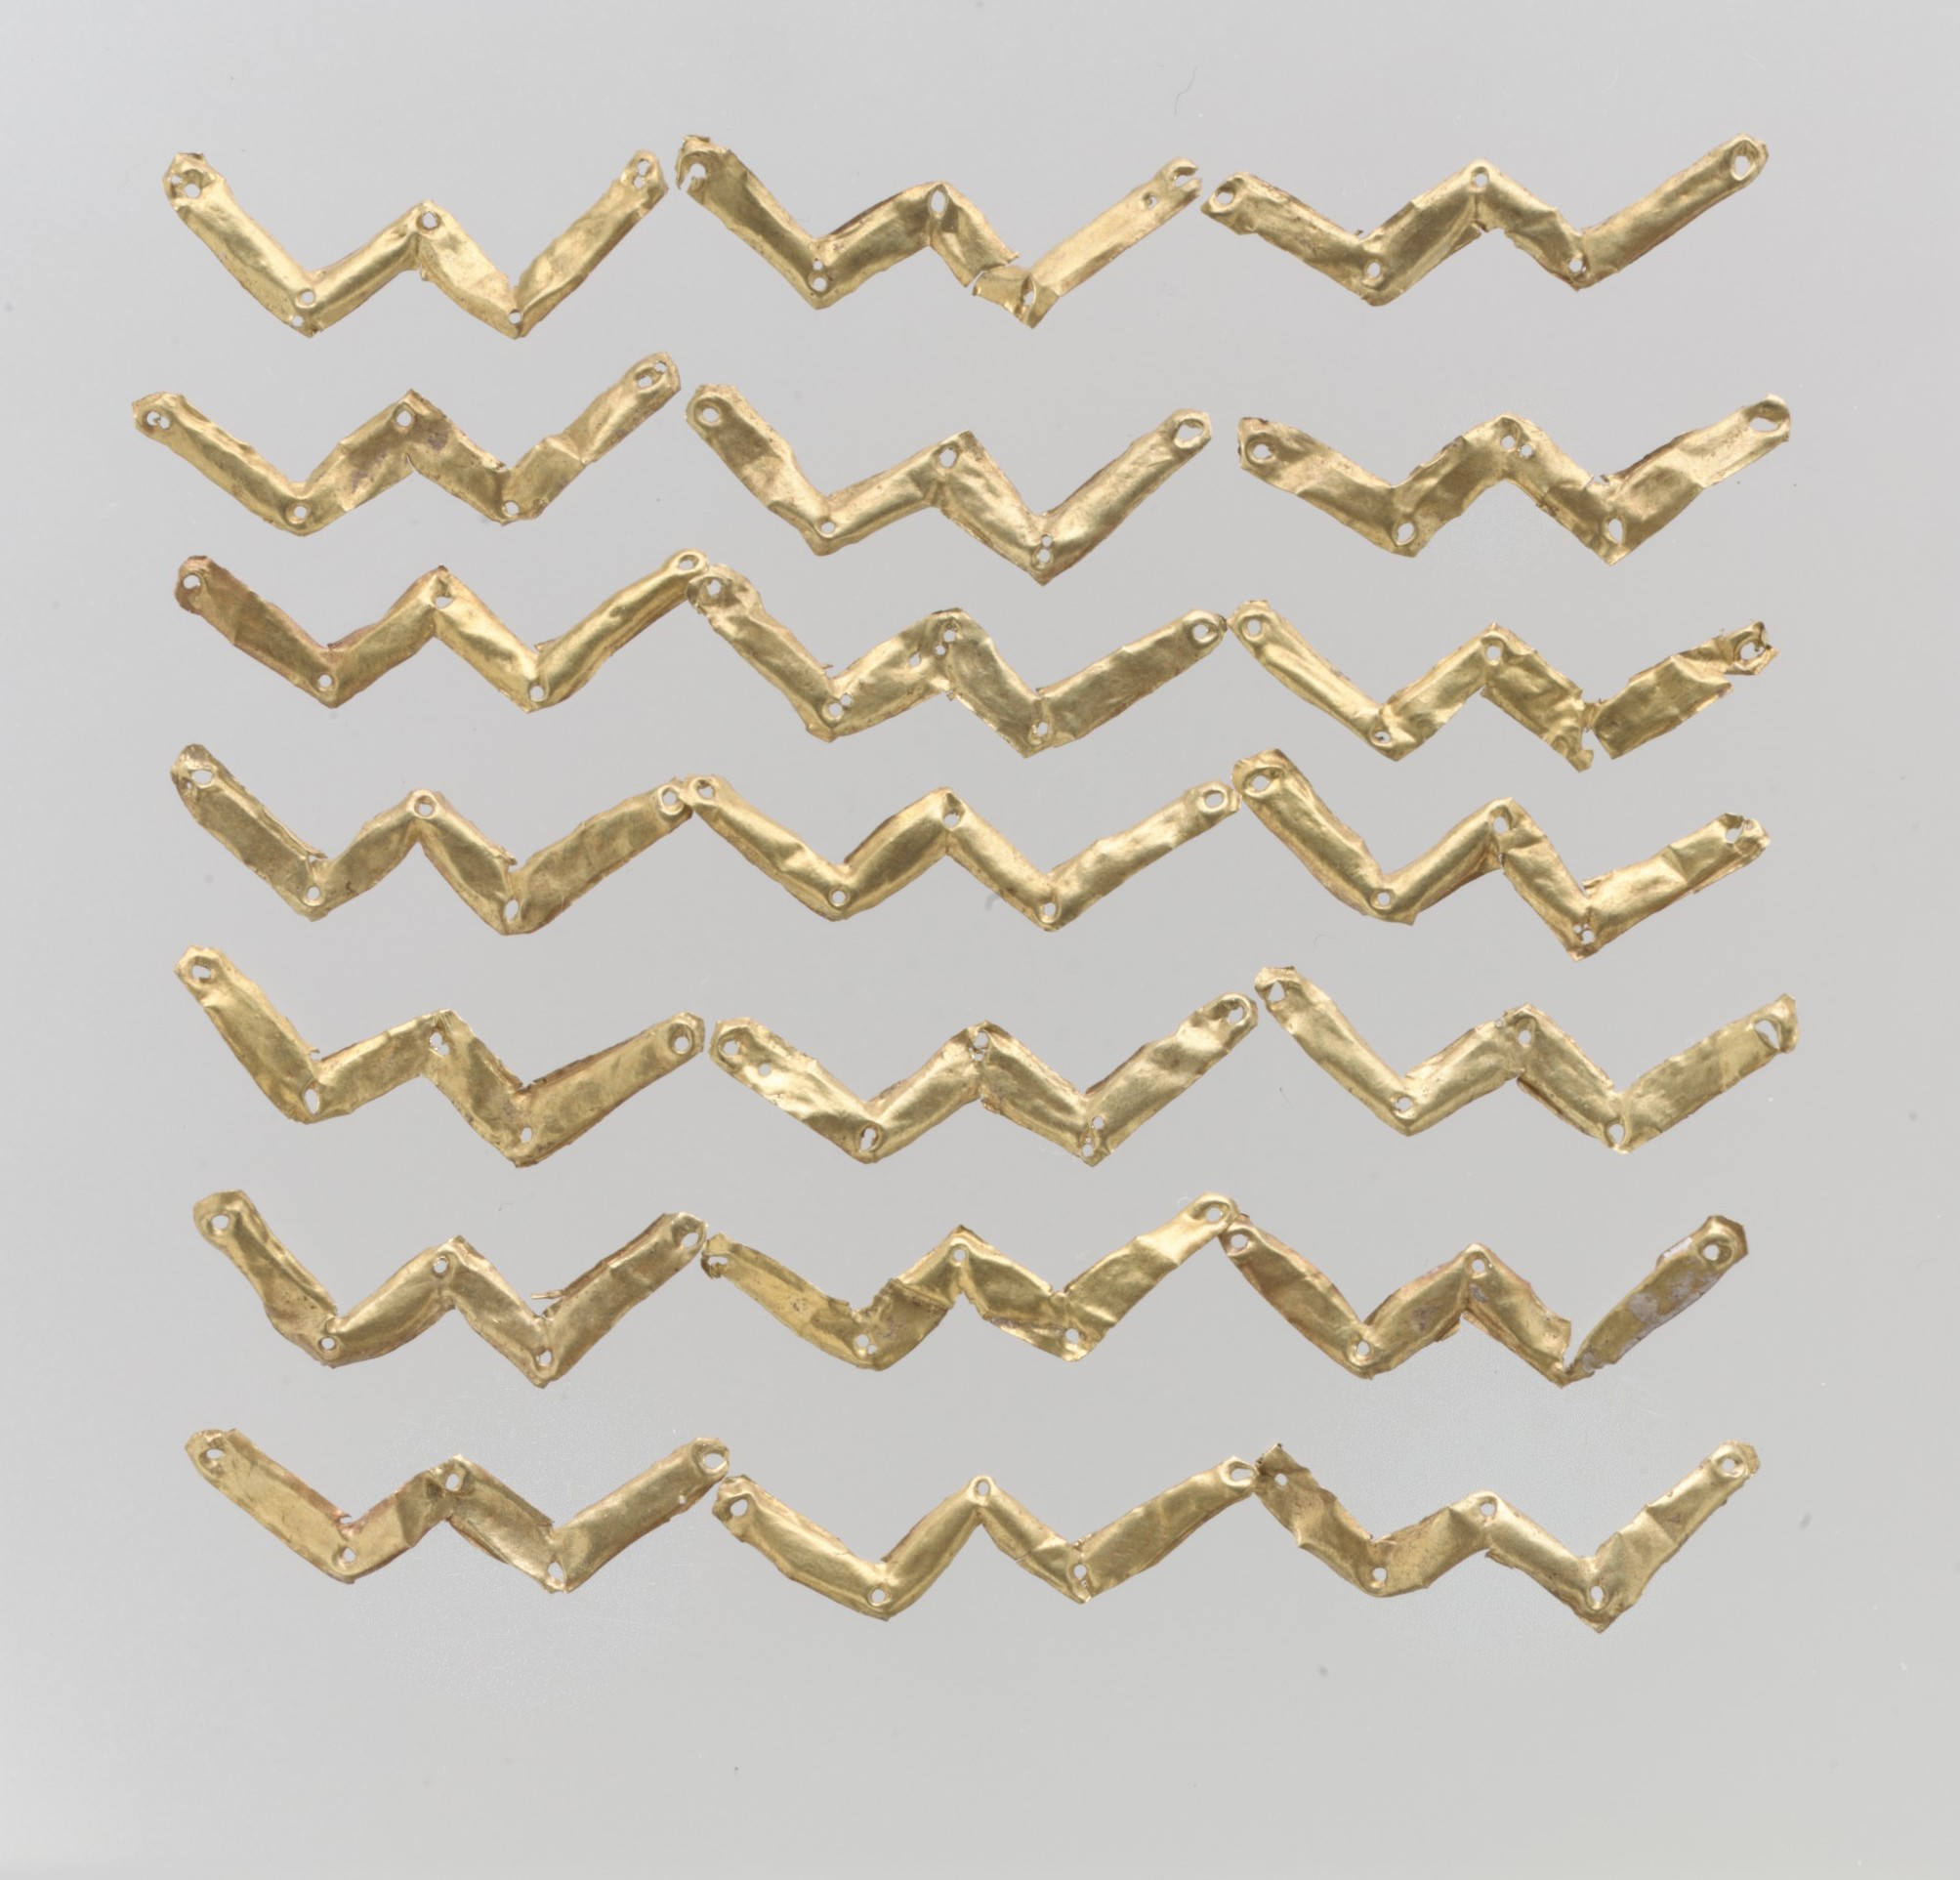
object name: applique, 44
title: Sheet appliques, 44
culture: east germanic or nomadic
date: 401-450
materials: gold